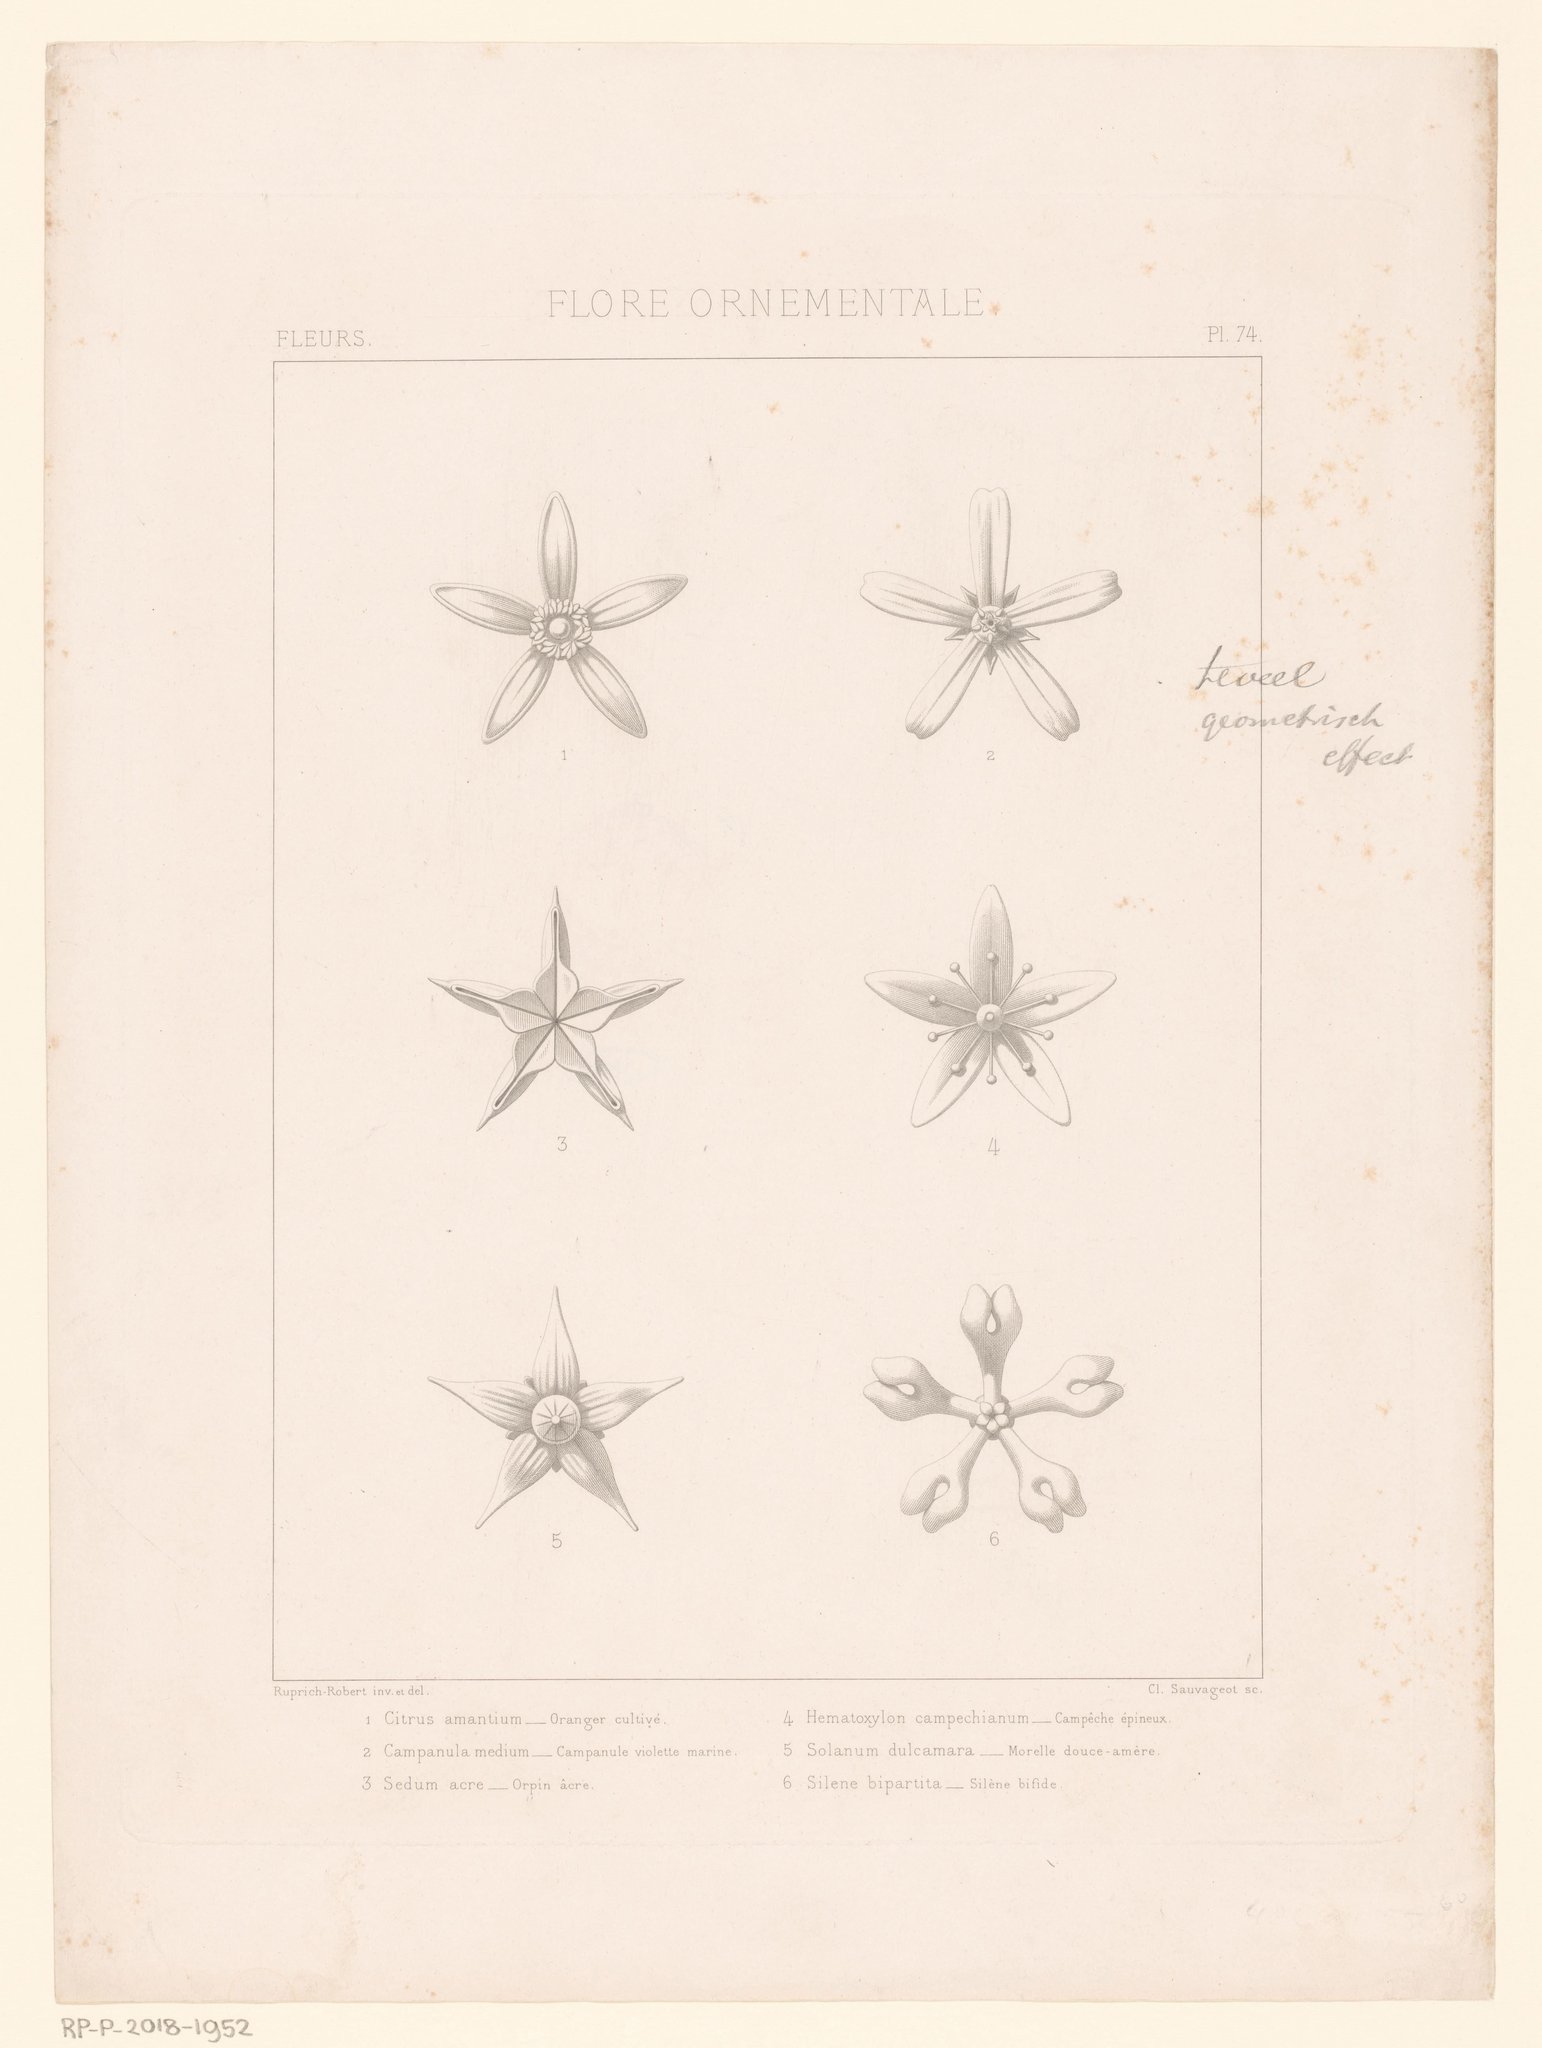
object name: book illustration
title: Studieblad met vooraanzichten van verschillende bloemen met vijf bladeren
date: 1842-1885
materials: paper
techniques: engraving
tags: model-books ~ implements of painter, flowers ~ ornament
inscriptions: collector's mark: Lugt 2228, collector's mark: Lugt 3937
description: Prent uit: Ruprich-Robert, Victor. Flore ornementale : essai sur la composition de l'ornement : éléments tirés de la nature et principes de leur application. Parijs: Dunod, 1876, nr. 74.